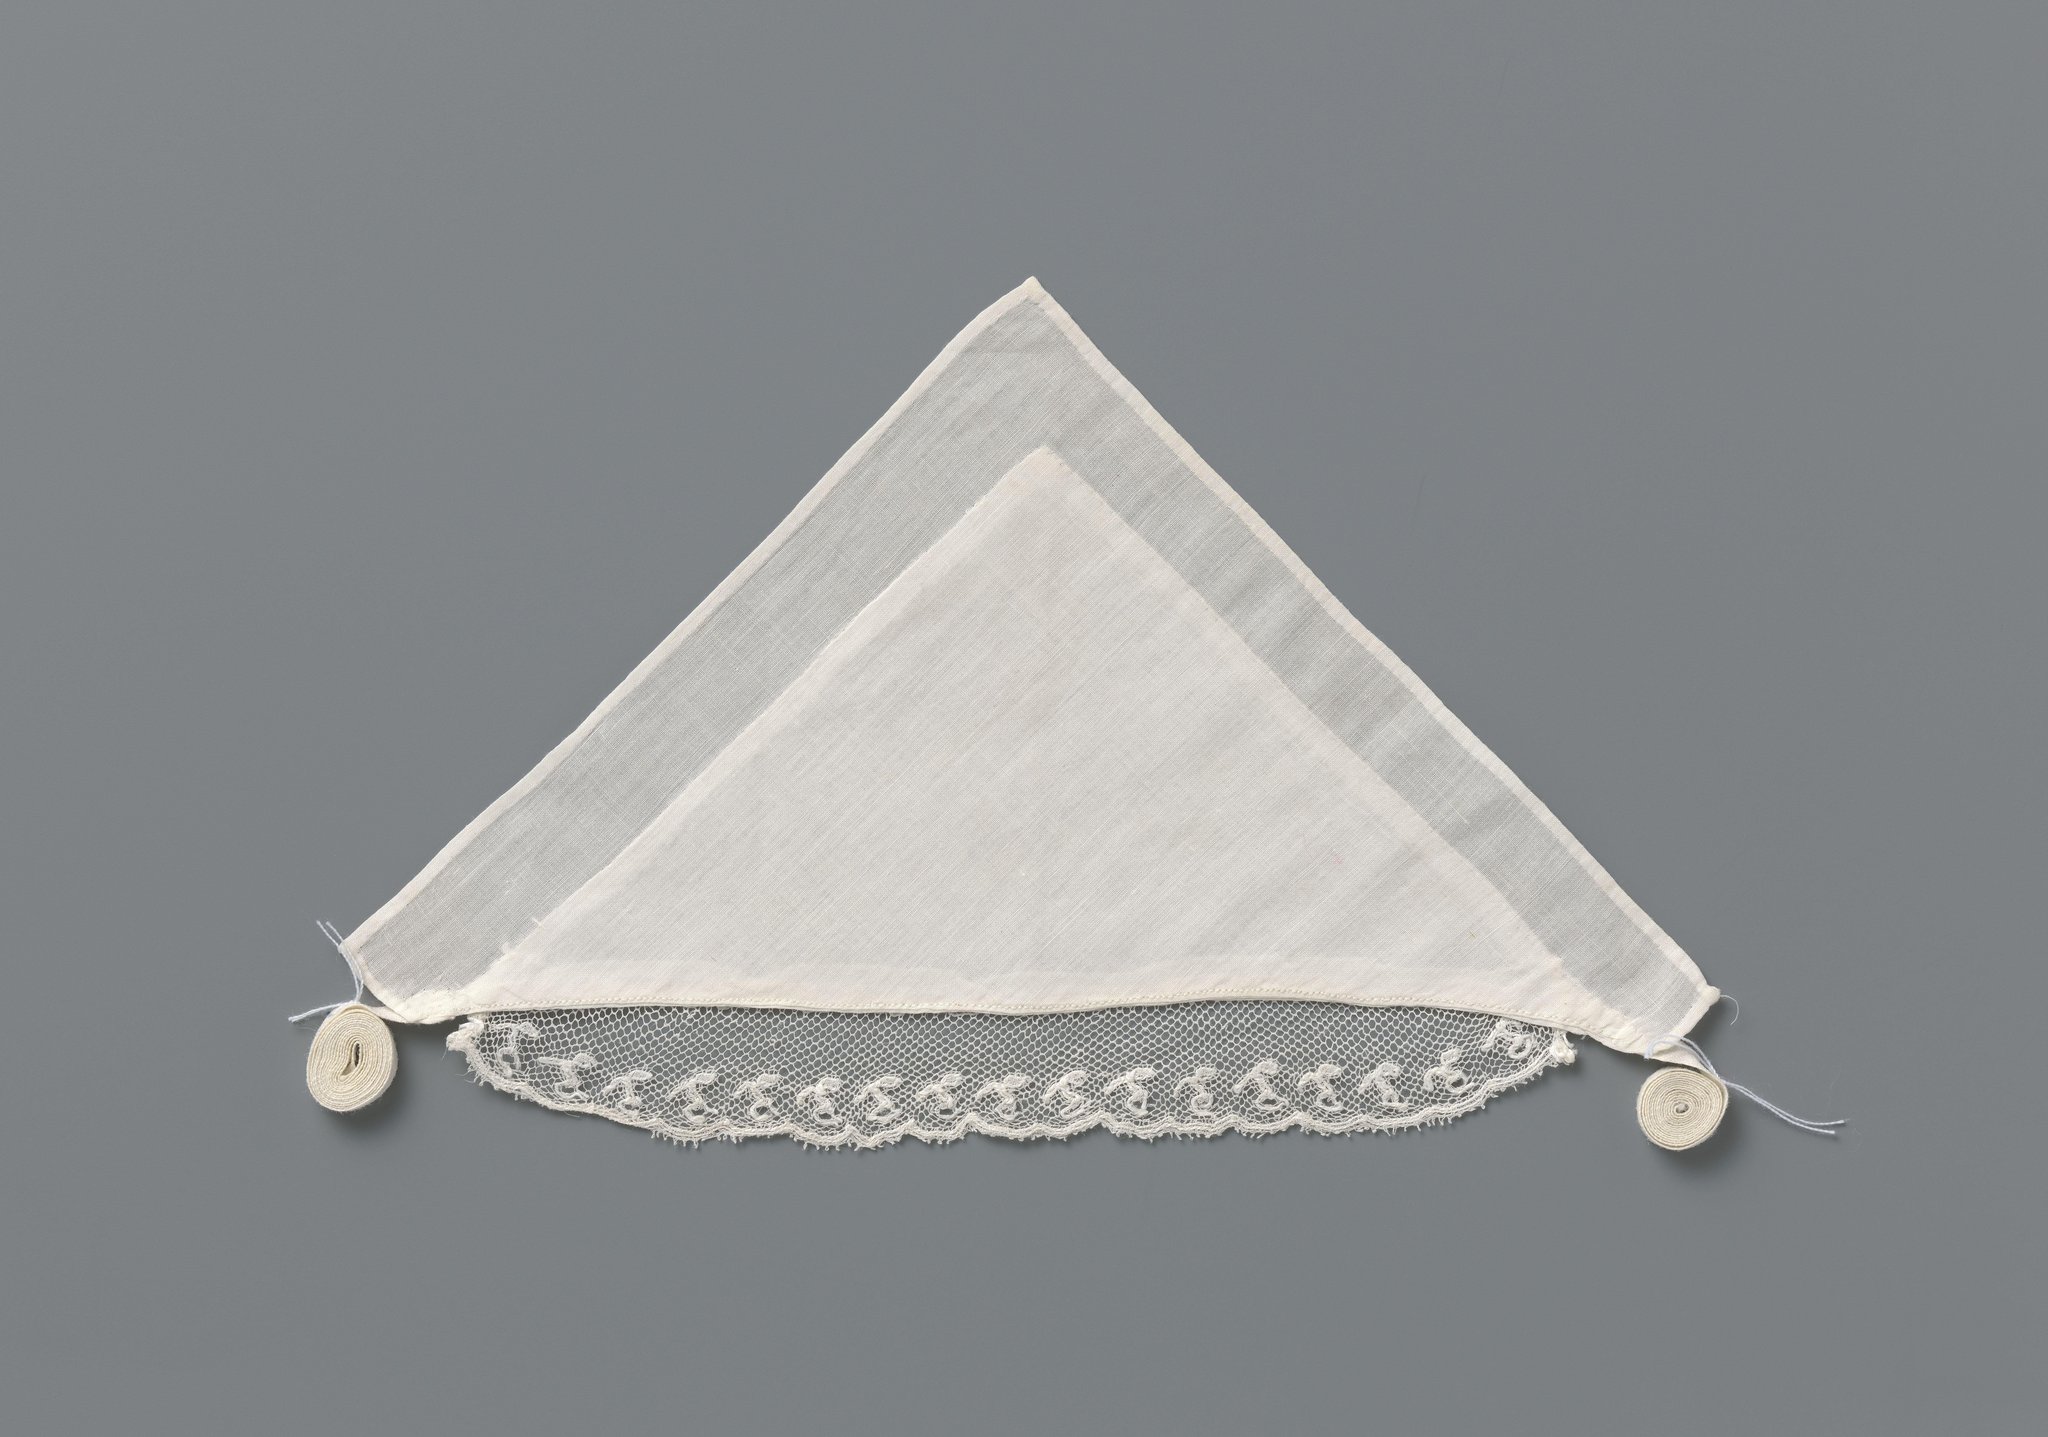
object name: childrenswear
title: Fontaneldoek van linnen met een strook Mechelse kant, met golvende rand en open bessen aan een tak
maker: Anonymous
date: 1700-1800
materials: linen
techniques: lace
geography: europe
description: Fontaneldoekje van linnen met strookje kloskant (Mechelen) met golvende rand en open besjes aan een takje.